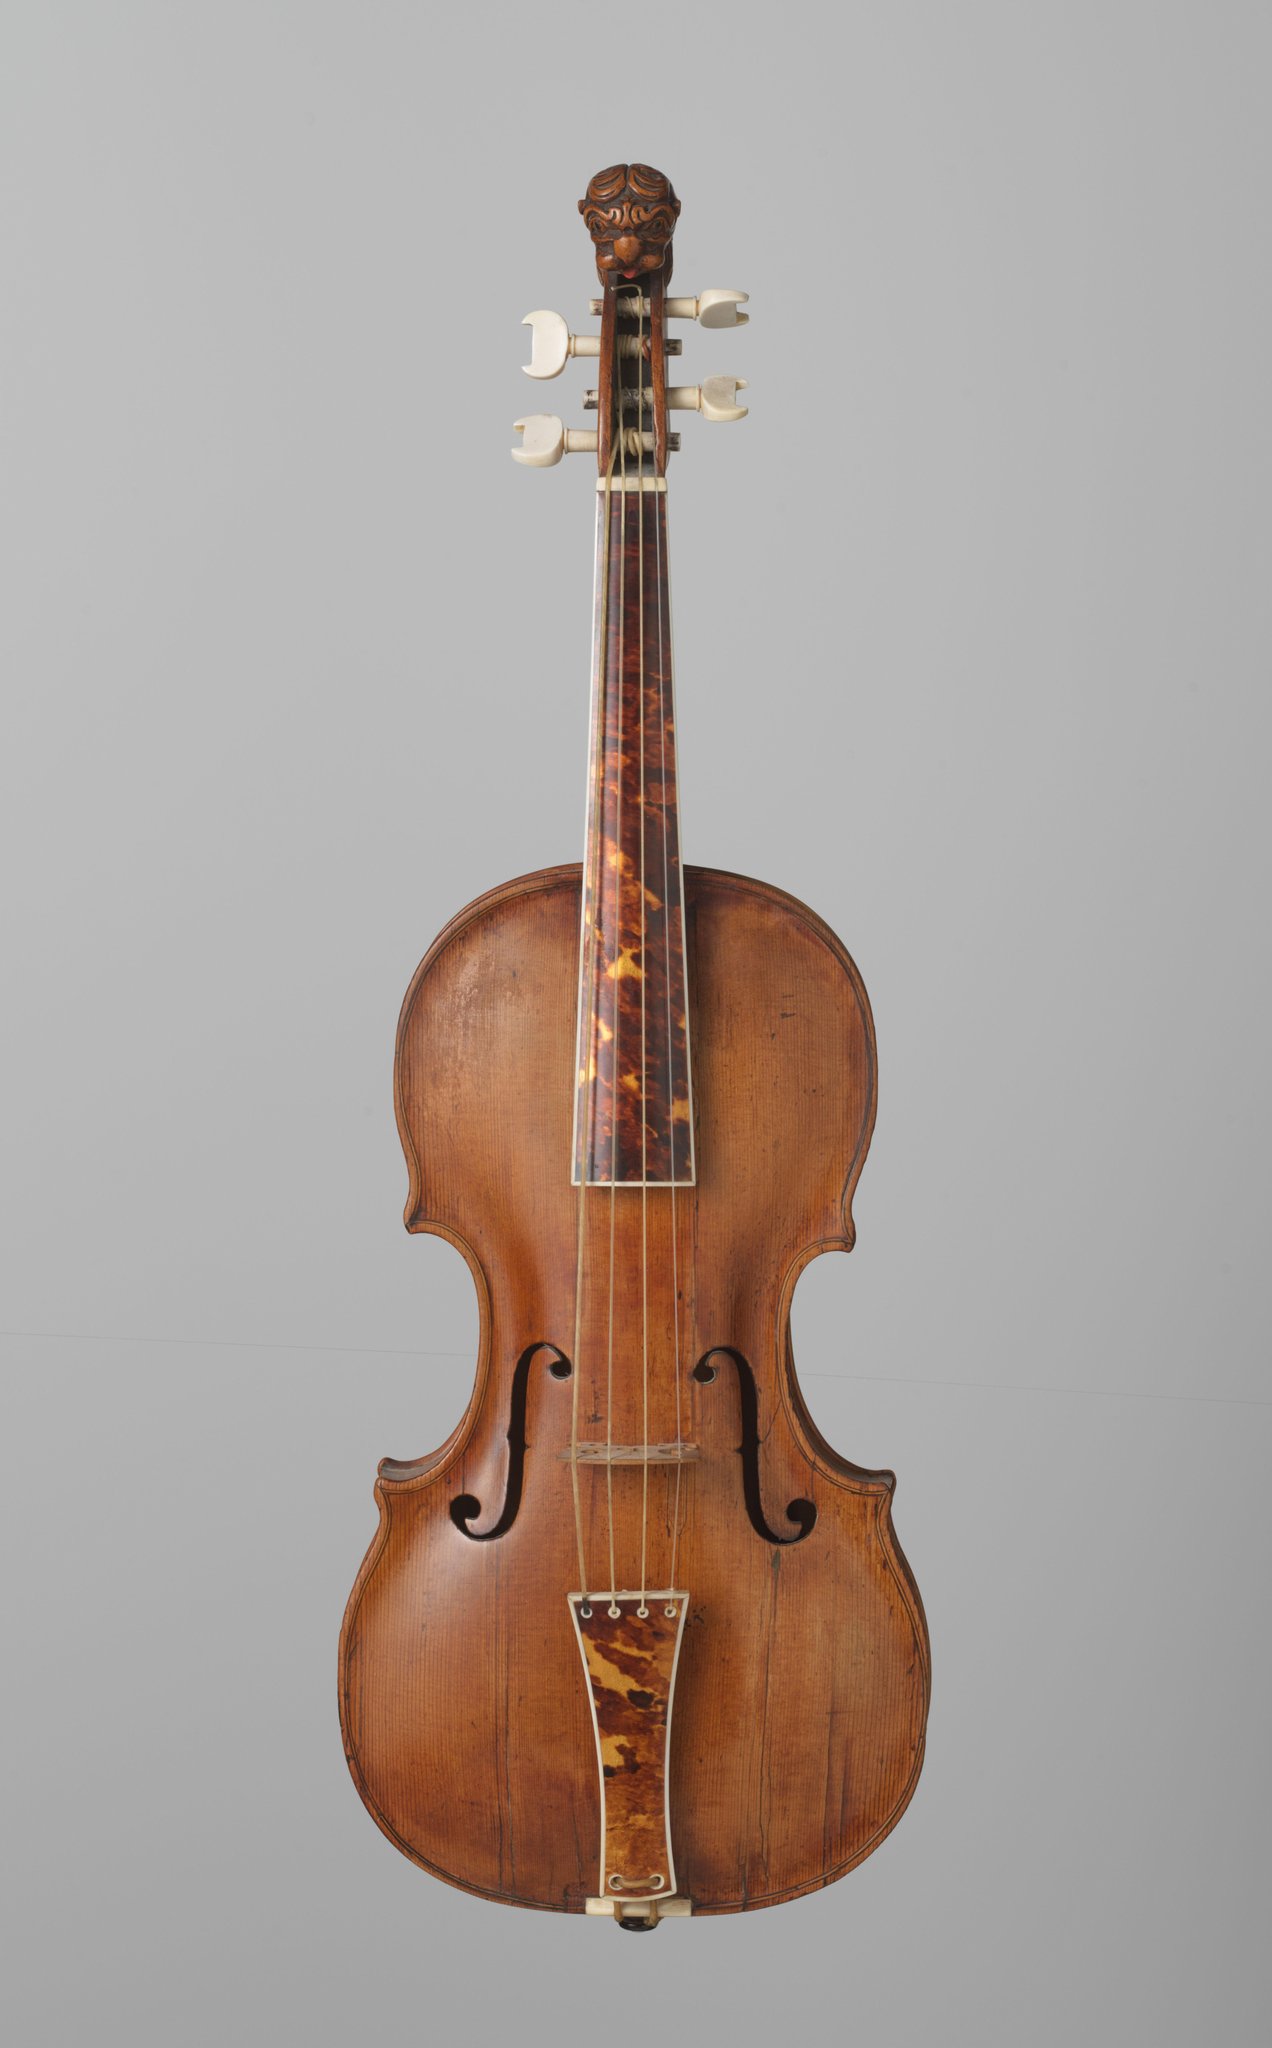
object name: bowed instrument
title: Violin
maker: leopold widhalm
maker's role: musical instrument maker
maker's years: 1722-1776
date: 1750-1806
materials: ivory, shell, wood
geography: nuremberg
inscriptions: : ‘LW’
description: Late 18th century violin, workshop of Leopold Widhalm in Nurnberg. Neck and bass bar are original, fittings are modern. The violin bears the letters L. and W. branded into the back.